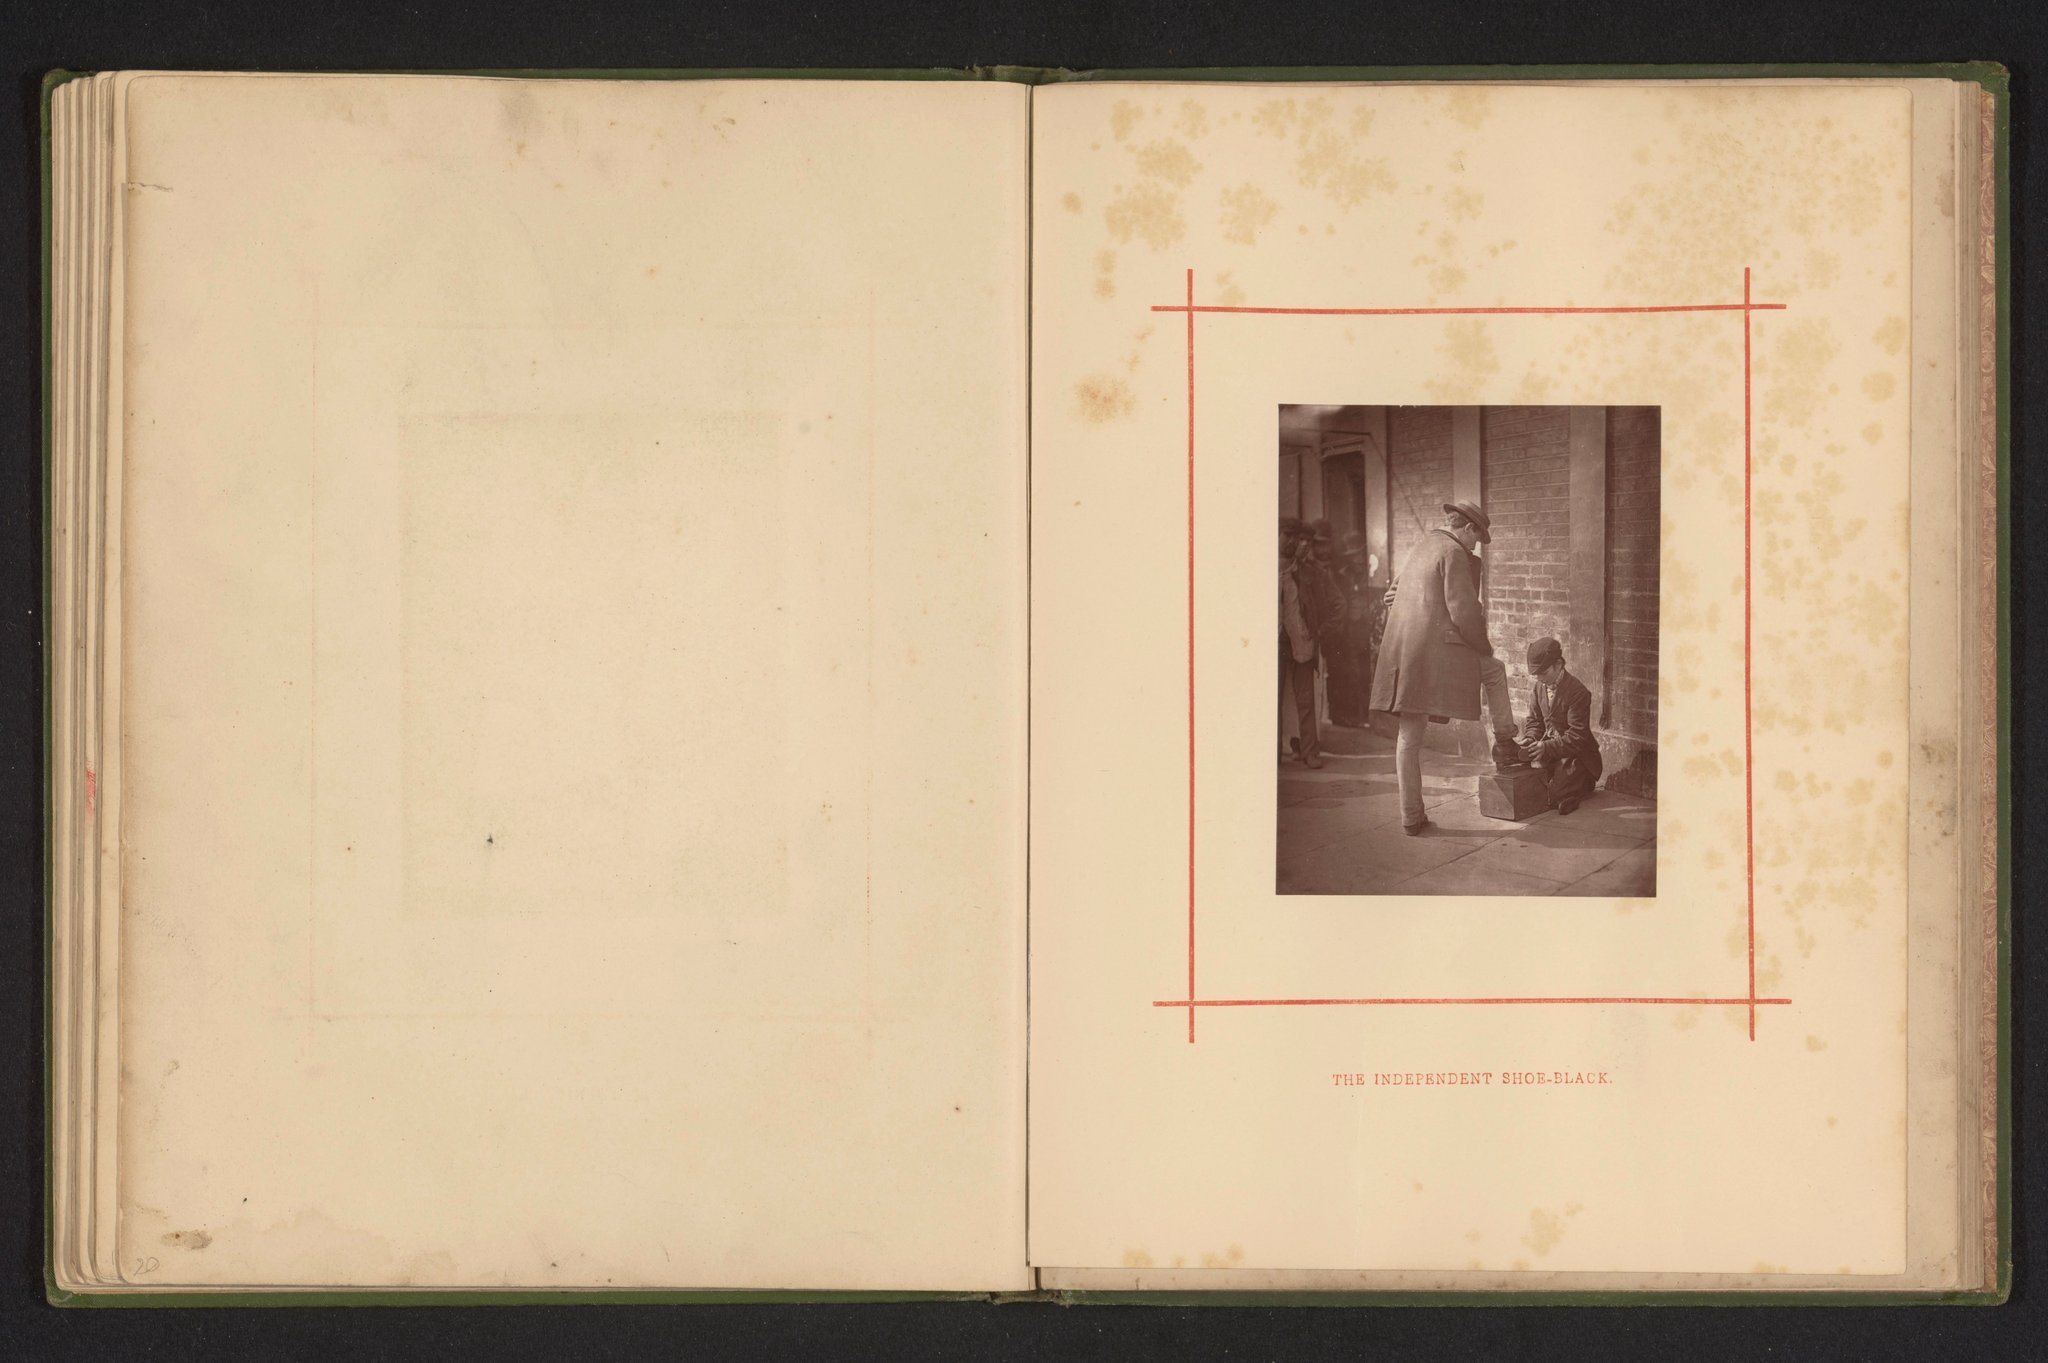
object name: photomechanical print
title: The independent shoe-black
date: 1871-1881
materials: paper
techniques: woodburytype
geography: london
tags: shoes, sandals, street